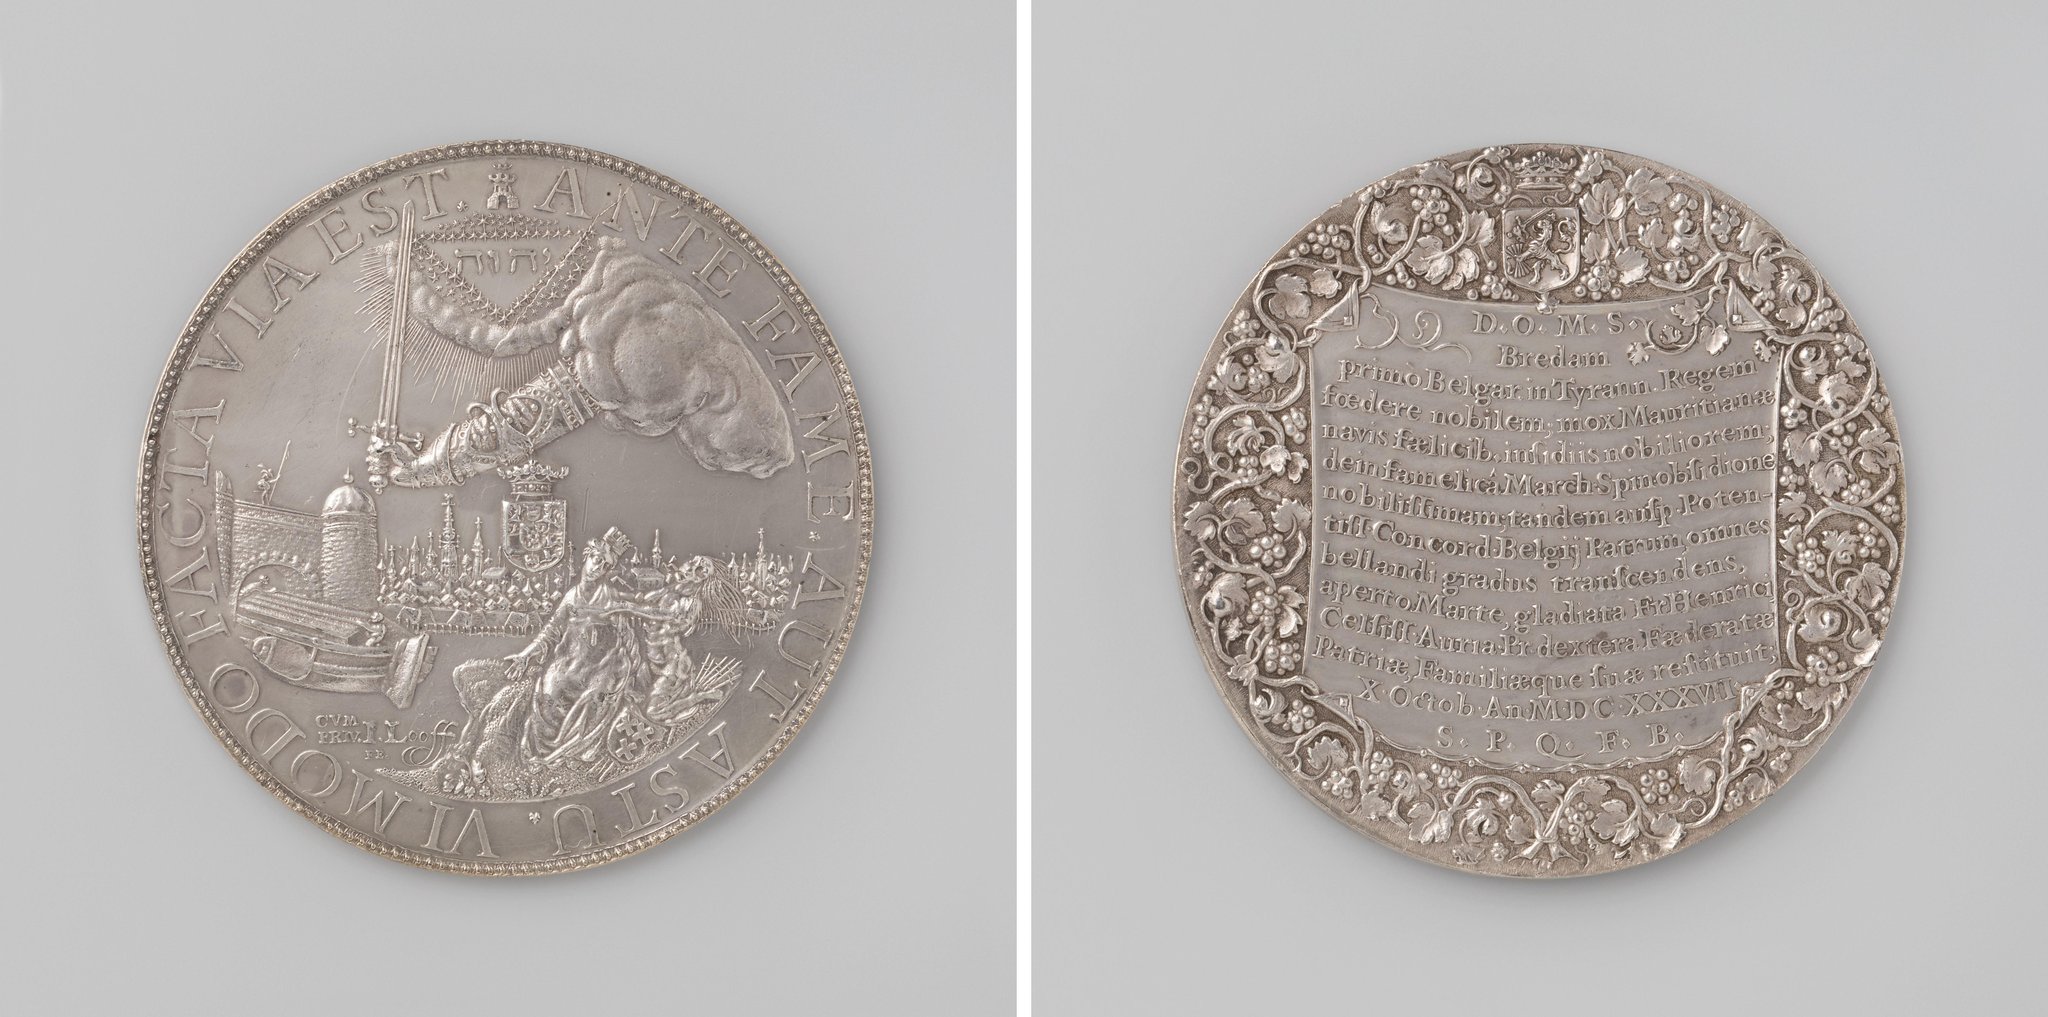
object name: history medal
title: Inname van Breda door Frederik Hendrik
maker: johannes looff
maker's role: die cutter, draughtsman, print maker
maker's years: -1651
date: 1637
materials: silver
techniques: striking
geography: middelburg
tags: delft, the hague, frederick henry (prince of orange)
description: Zilveren penning. Voorzijde: gezicht op de veroverde stad met het turfschip, daarboven arm uit wolken met zwaard en gekroond wapenschild; op voorgrond Breda voorgesteld als vrouw door Honger bij keel gegrepen, binnen omschrift. Keerzijde: opschrift omgeven door wijnranken met daarin gekroond wapenschild.